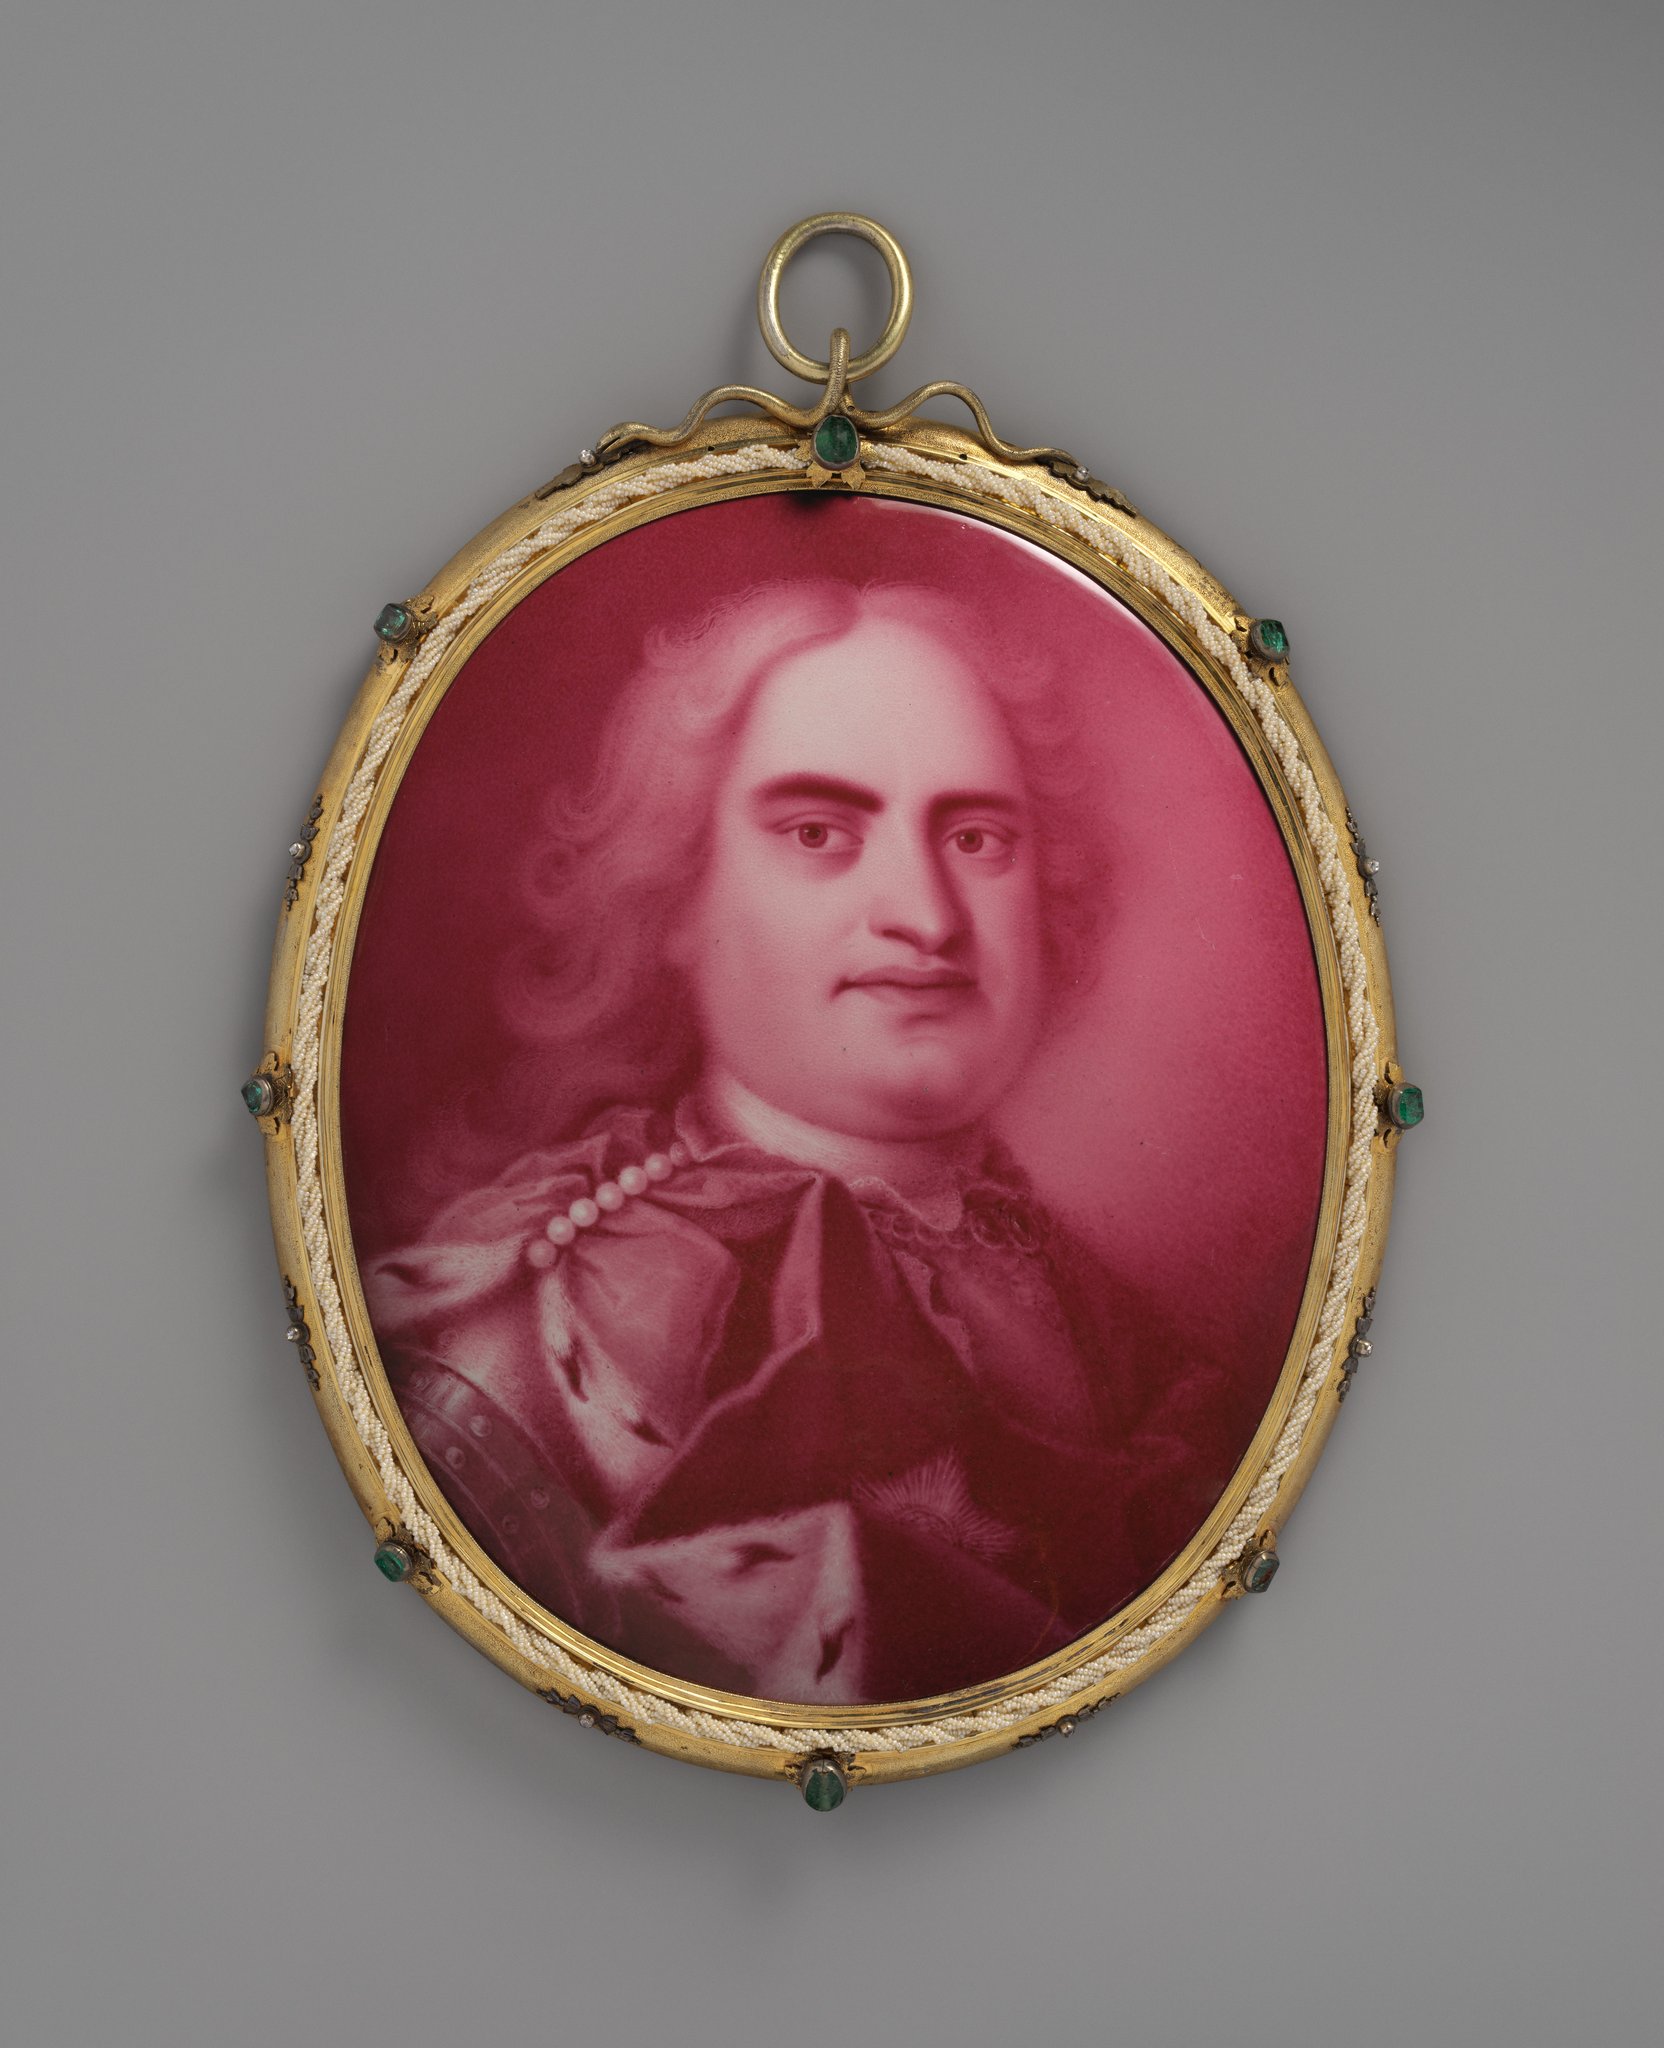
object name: portrait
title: Portrait of Augustus II, Elector of Saxony, King of Poland, and Grand Duke of Lithuania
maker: georg friedrich dinglinger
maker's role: enameler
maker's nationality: german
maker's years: 1666-1720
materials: copper, diamond, gemstone, enamel, gilt, pearl, silver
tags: men,portraits